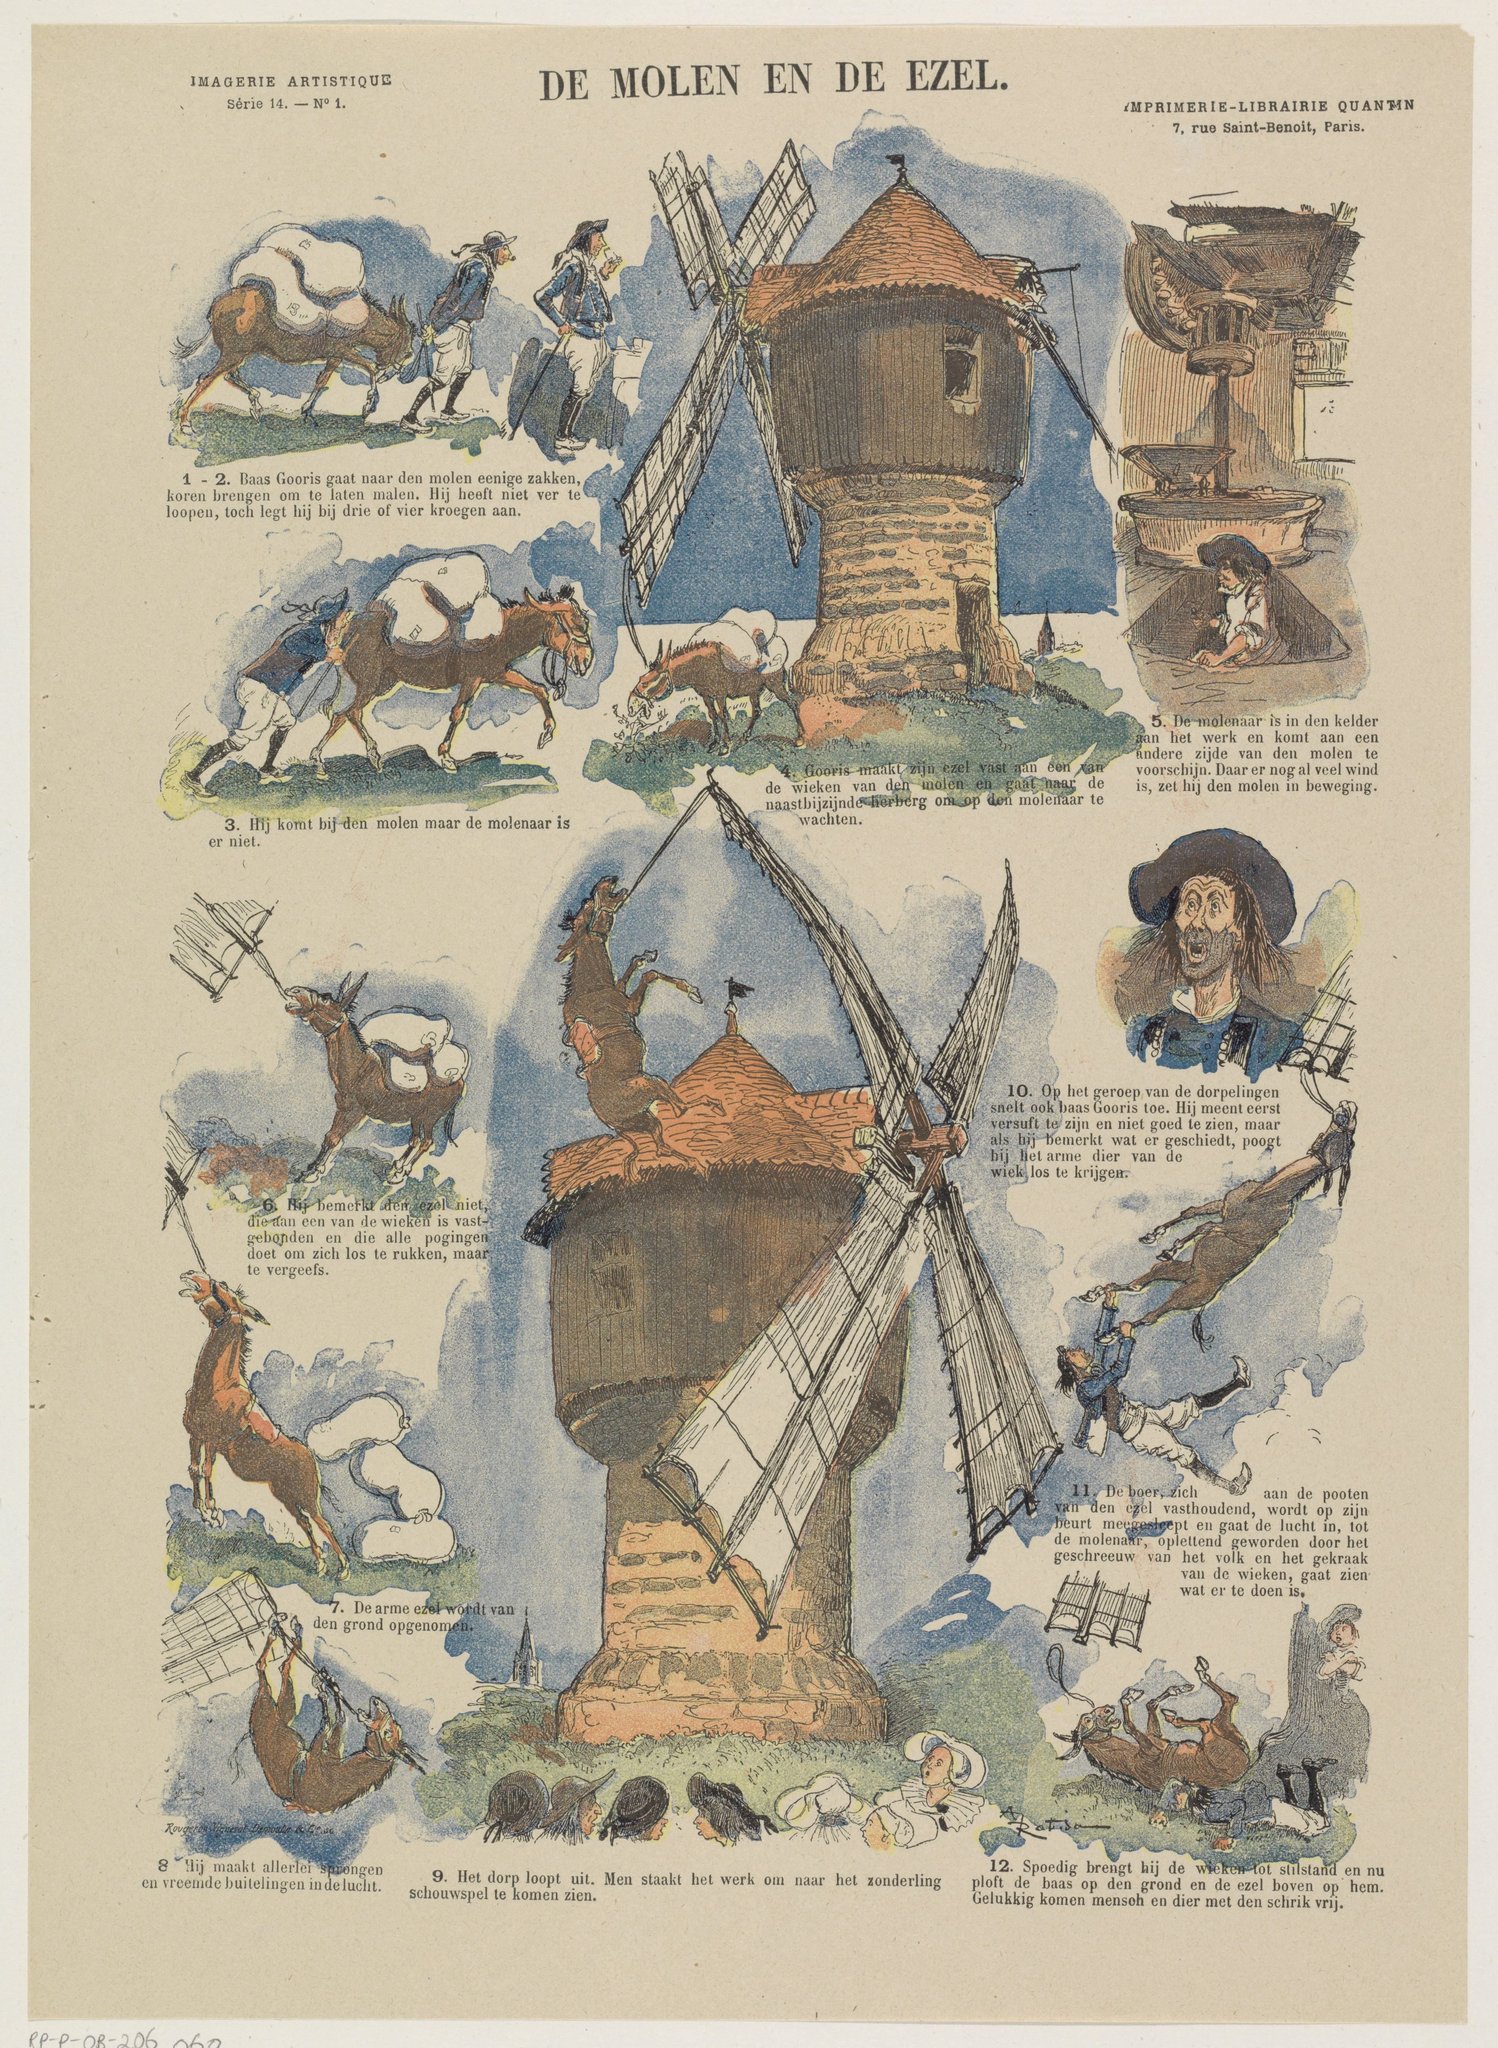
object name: print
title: De molen en de ezel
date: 1876-1890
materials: paper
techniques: lithograph, letterpress printing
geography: paris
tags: ass, donkey, farmers, tales and fairy tales, windmill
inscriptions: collector's mark: Lugt 2760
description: Blad met 11 voorstellingen van een boer die zijn ezel aan de wieken van een molen bindt. Als de molen draait gaat de ezel mee de lucht in. Onder elke afbeelding een onderschrift. Genummerd linksboven: Série 14. - No. 1.